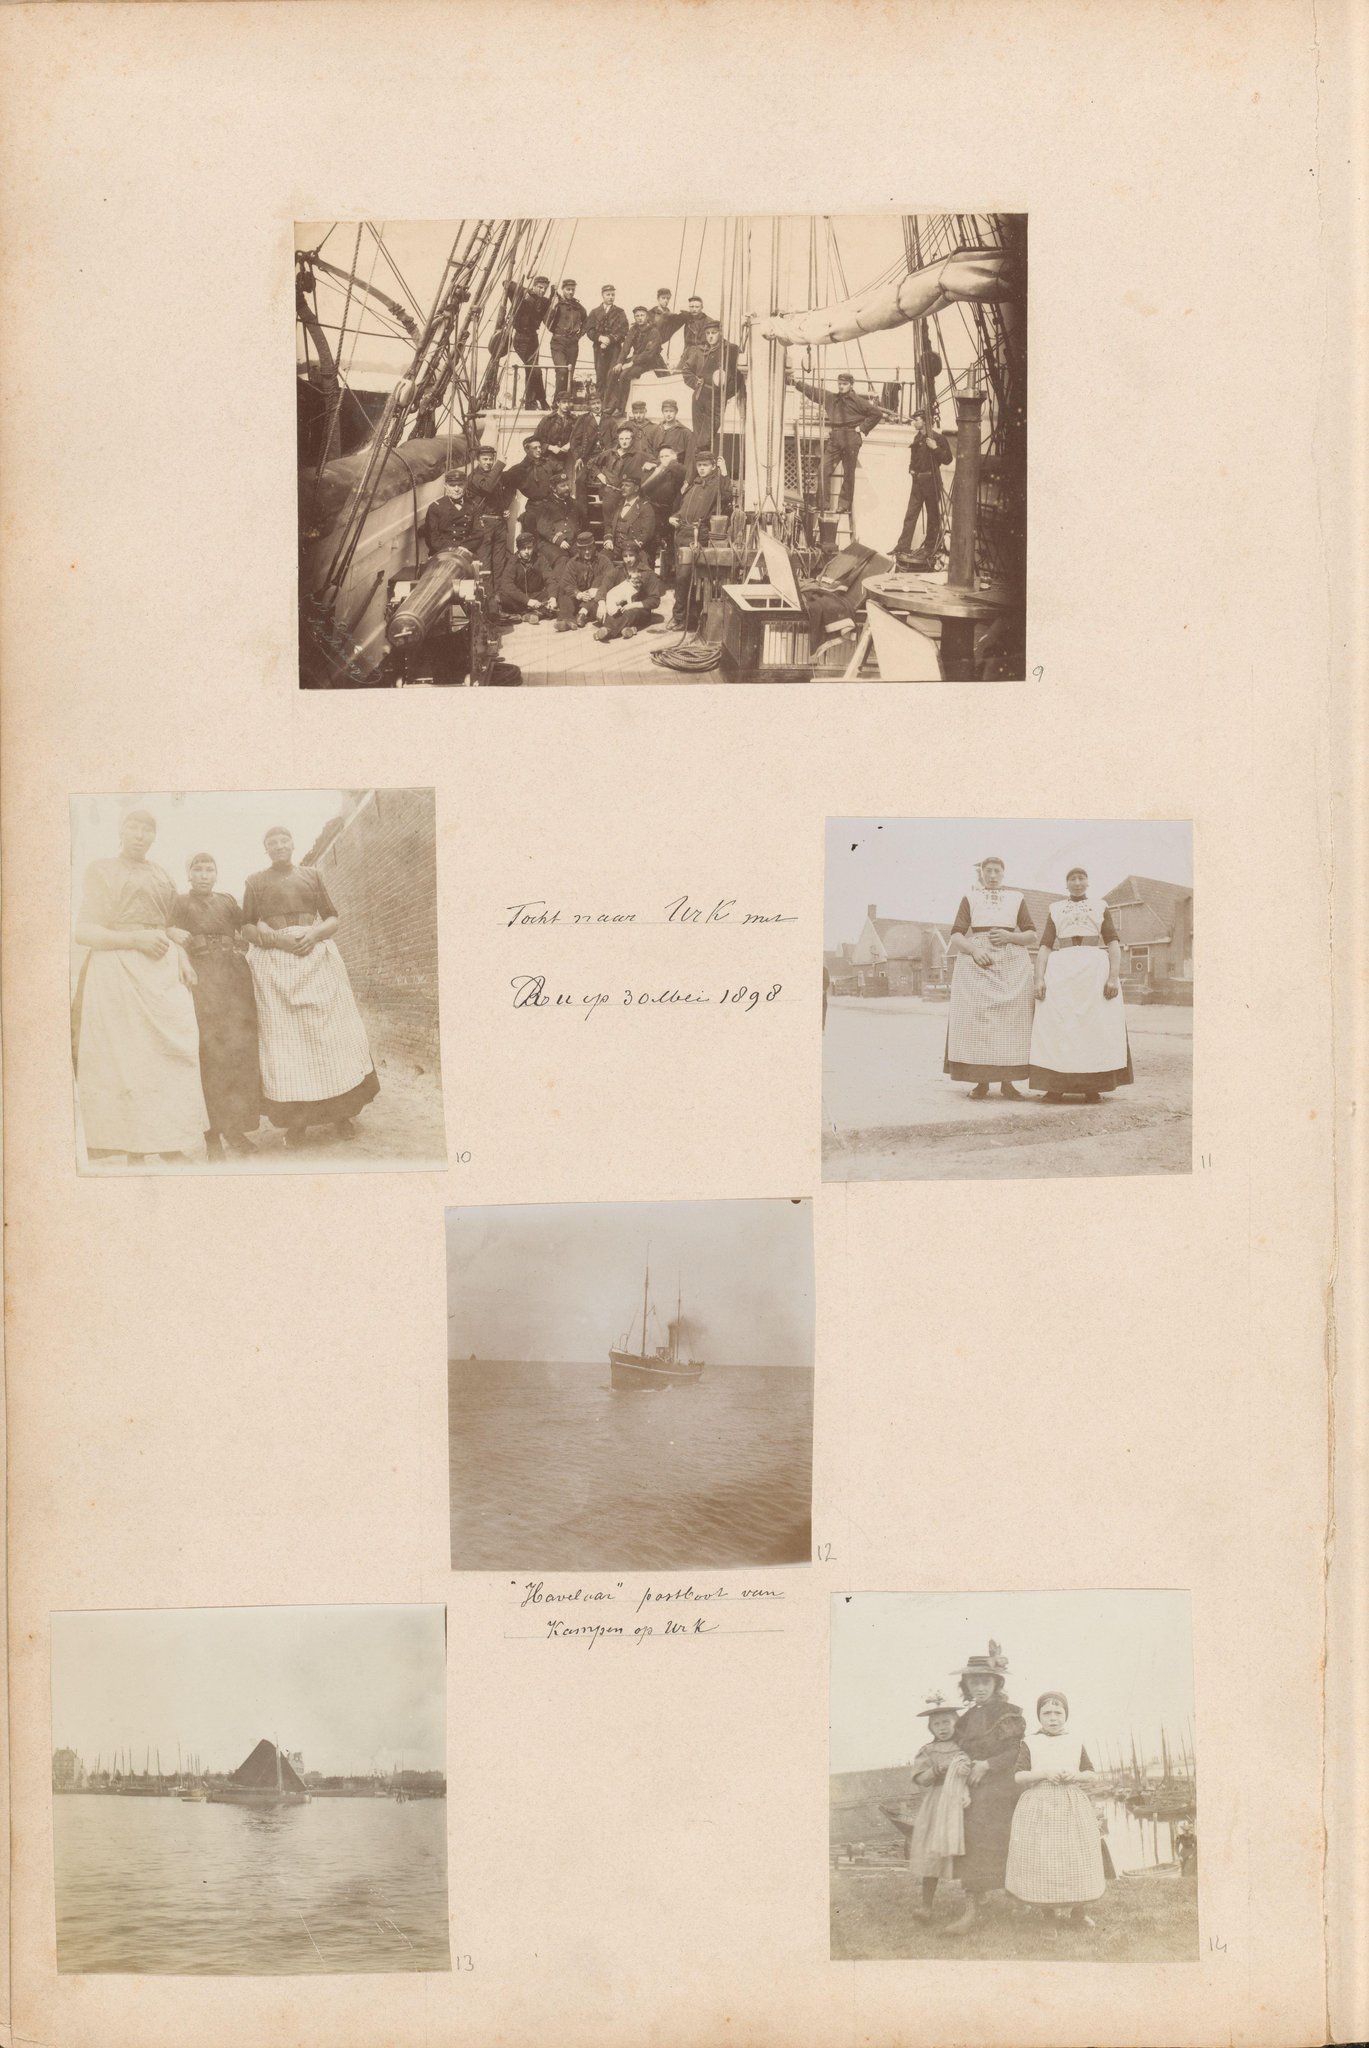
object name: album leaf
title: Bemanning aan dek van een schip, mogelijk van het gepantserde fregat 'Gloire'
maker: Anonymous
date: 1805-1863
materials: paper, photographic support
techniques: albumen print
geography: toulon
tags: crew ~ ship, sailing-ship, sailing-boat (with name), steamship, motorship, toulon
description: Onderdeel van Fotoalbum van Robert Daniel Crommelin (1841-1907).